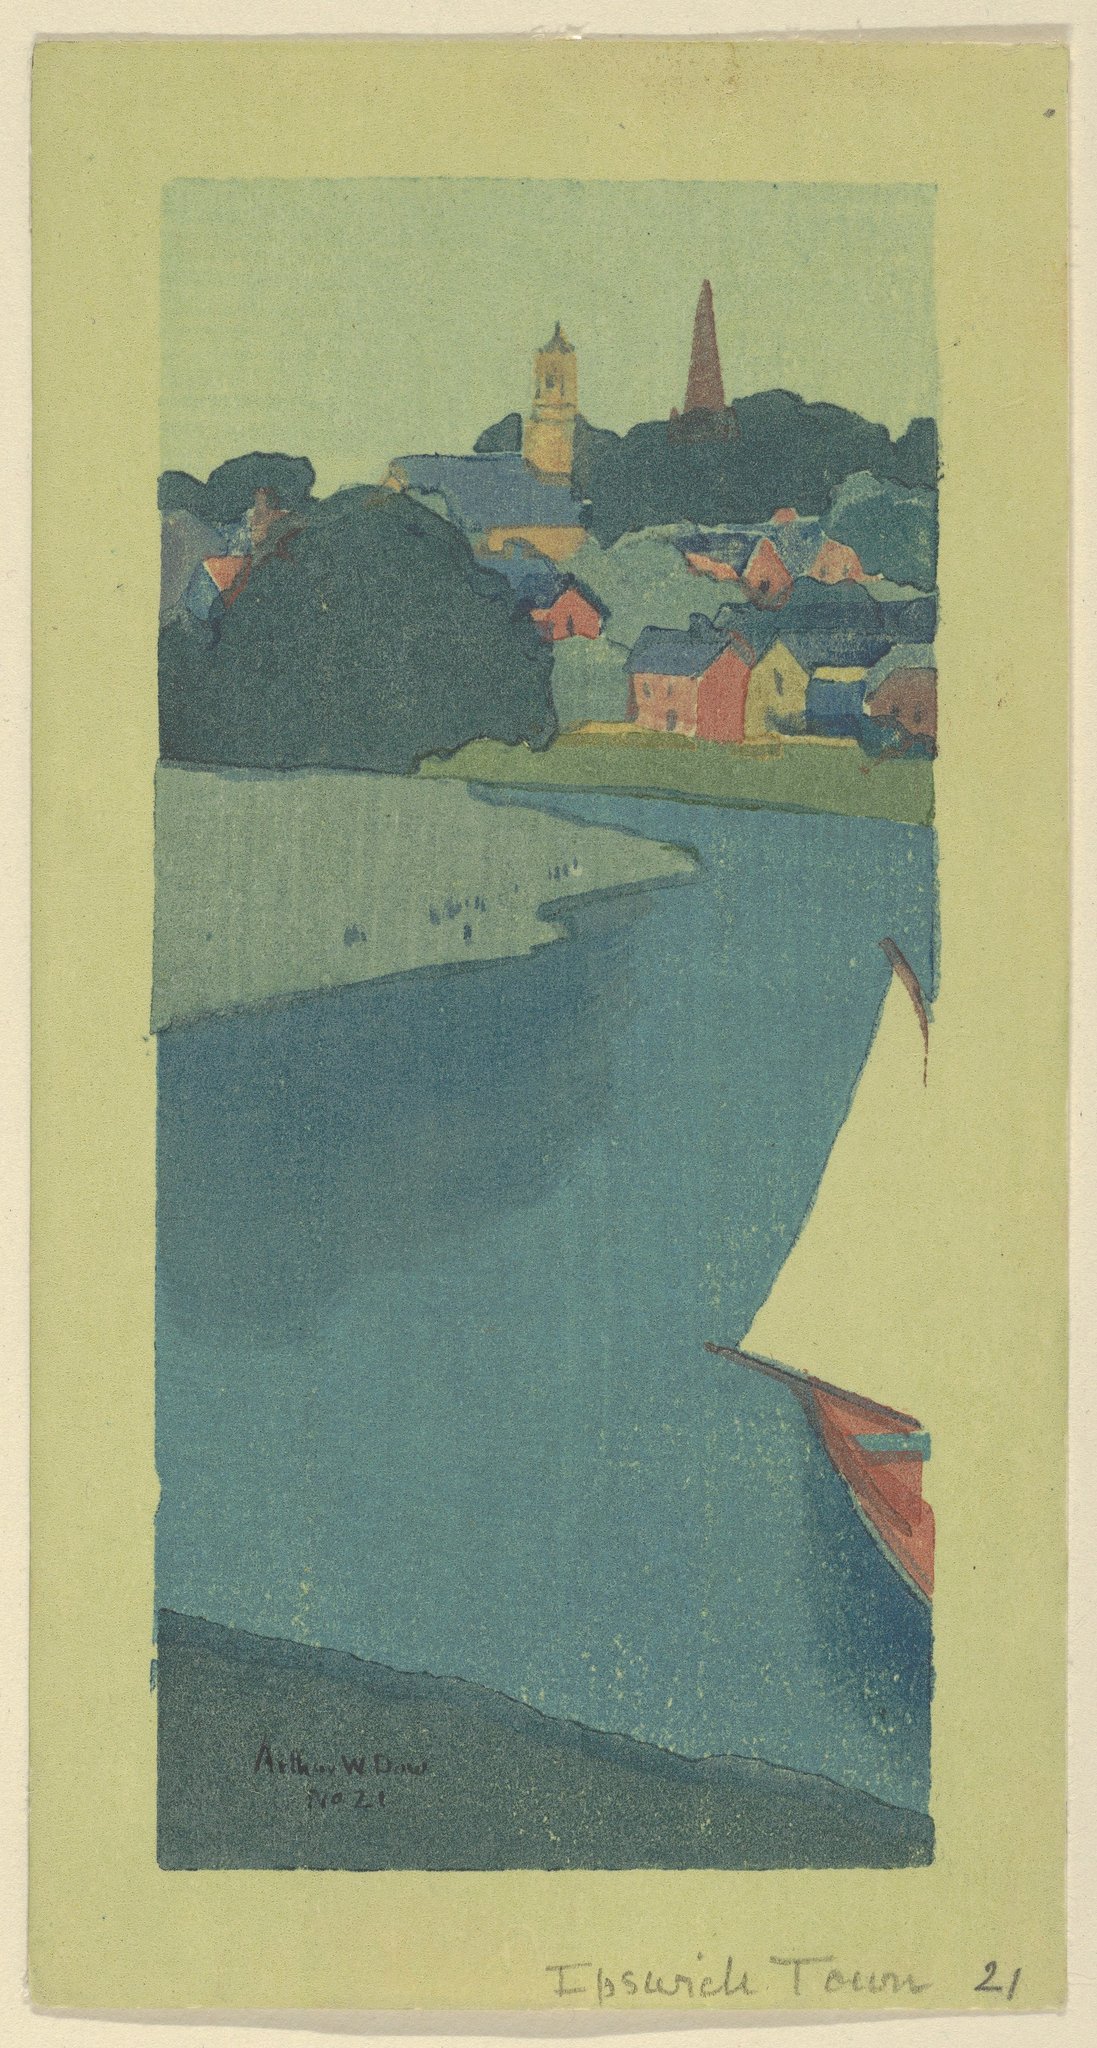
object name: print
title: Ipswich Town, or Harbor Scene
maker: arthur wesley dow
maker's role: artist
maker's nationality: american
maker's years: 1857-1922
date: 1893-1895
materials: paper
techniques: woodcut, stain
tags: towns,rivers